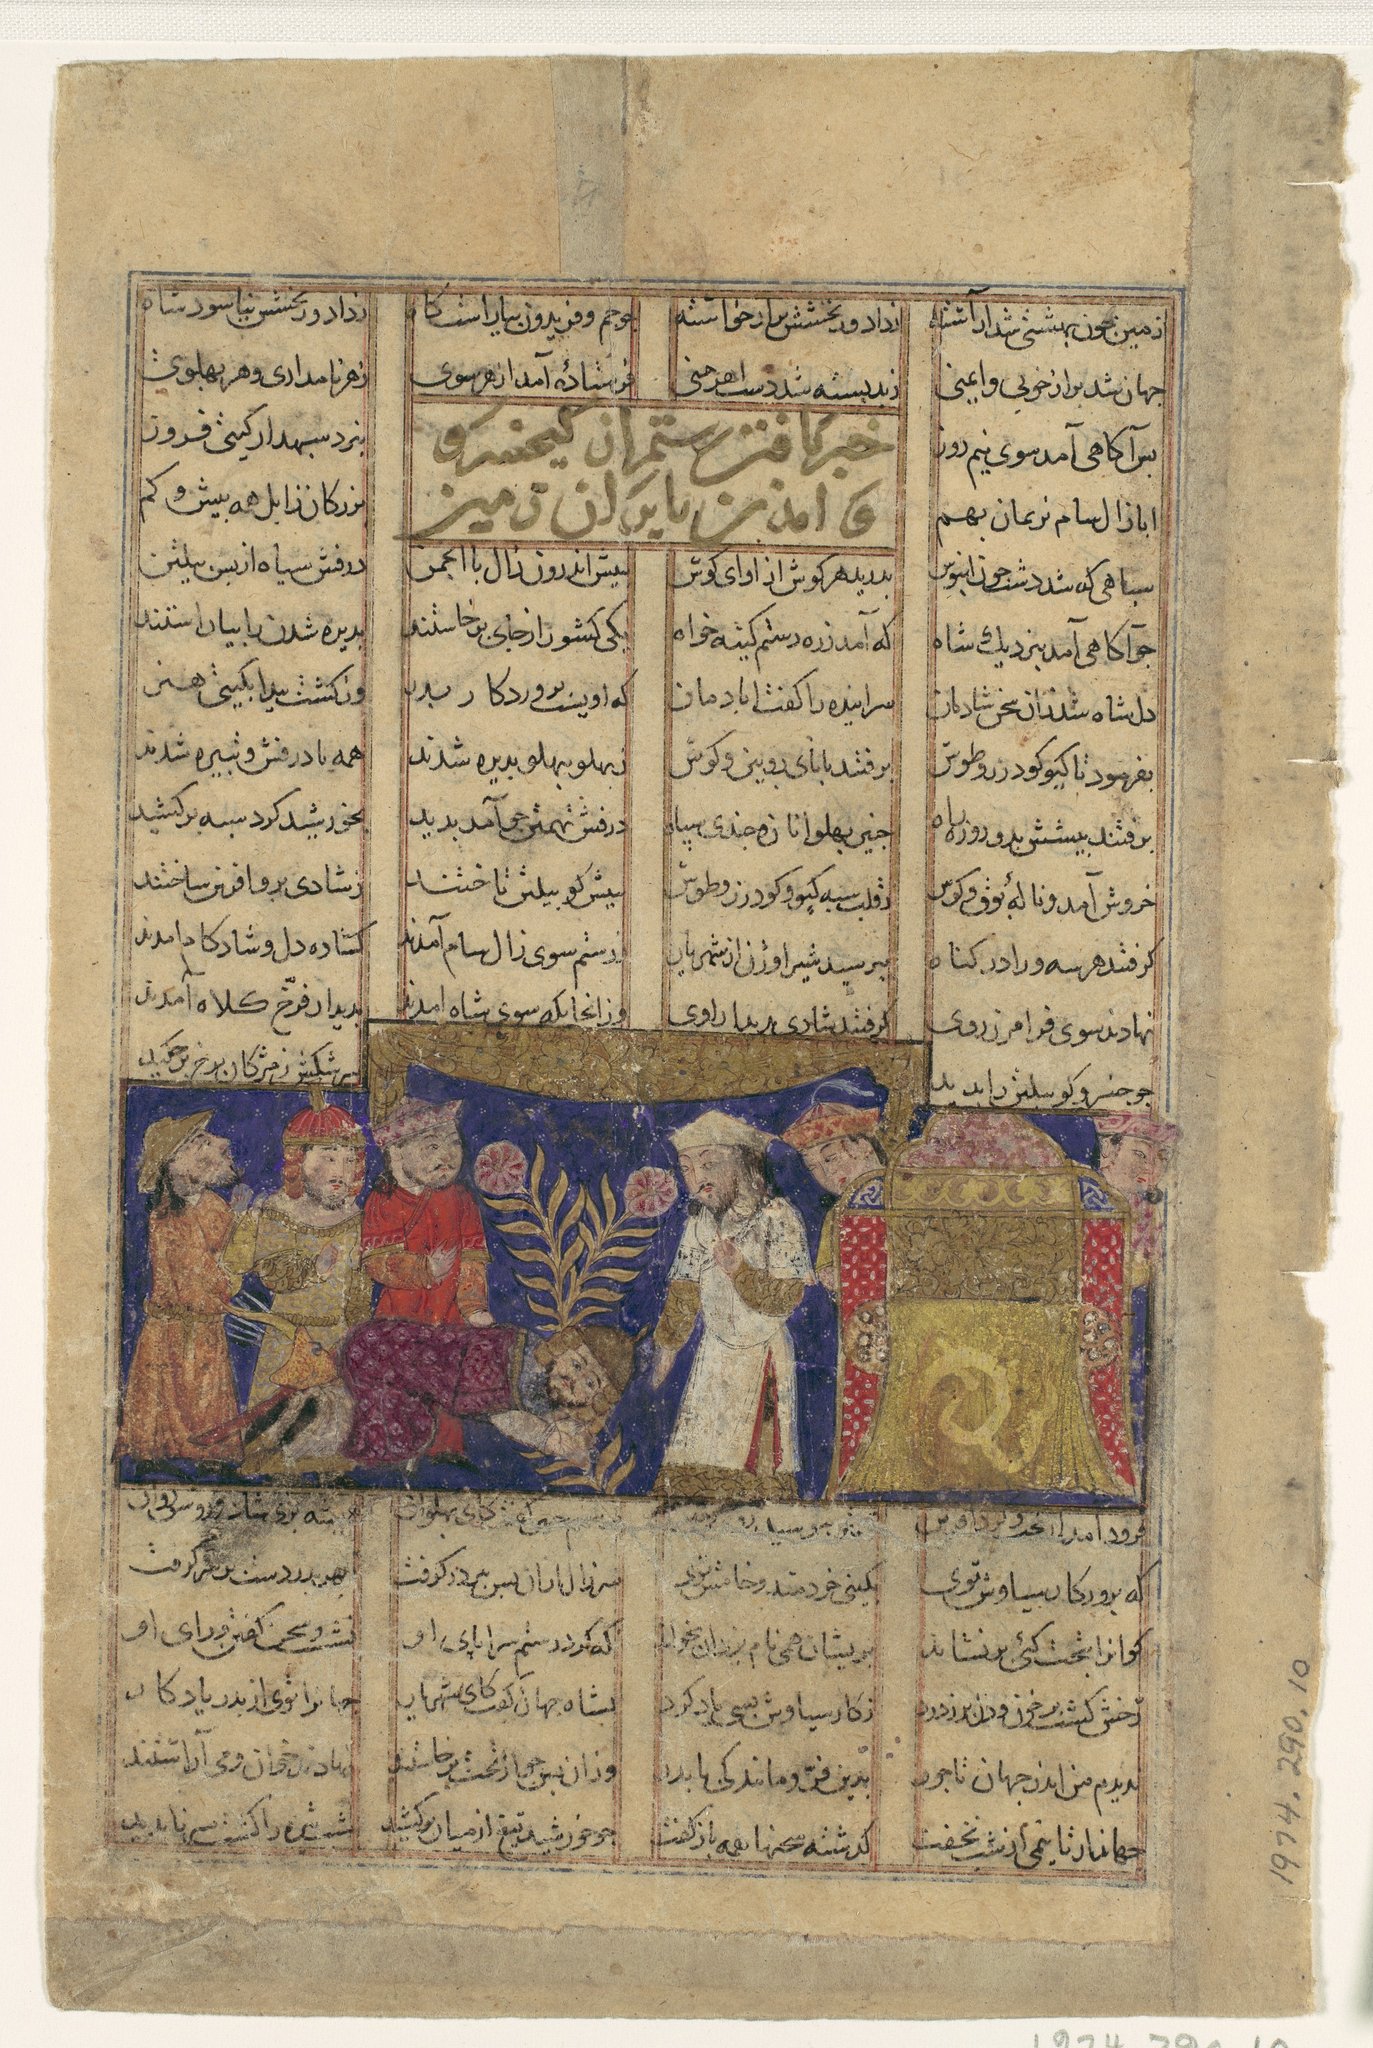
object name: folio from an illustrated manuscript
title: "Rustam Comes from Kabul to Pay Homage to Kai Khusrau", Folio from a Shahnama (Book of Kings) of Firdausi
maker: abu'l qasim firdausi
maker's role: author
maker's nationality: iranian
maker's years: 935-1020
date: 1330-1340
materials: gold, ink, paper, silver, watercolor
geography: iran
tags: men